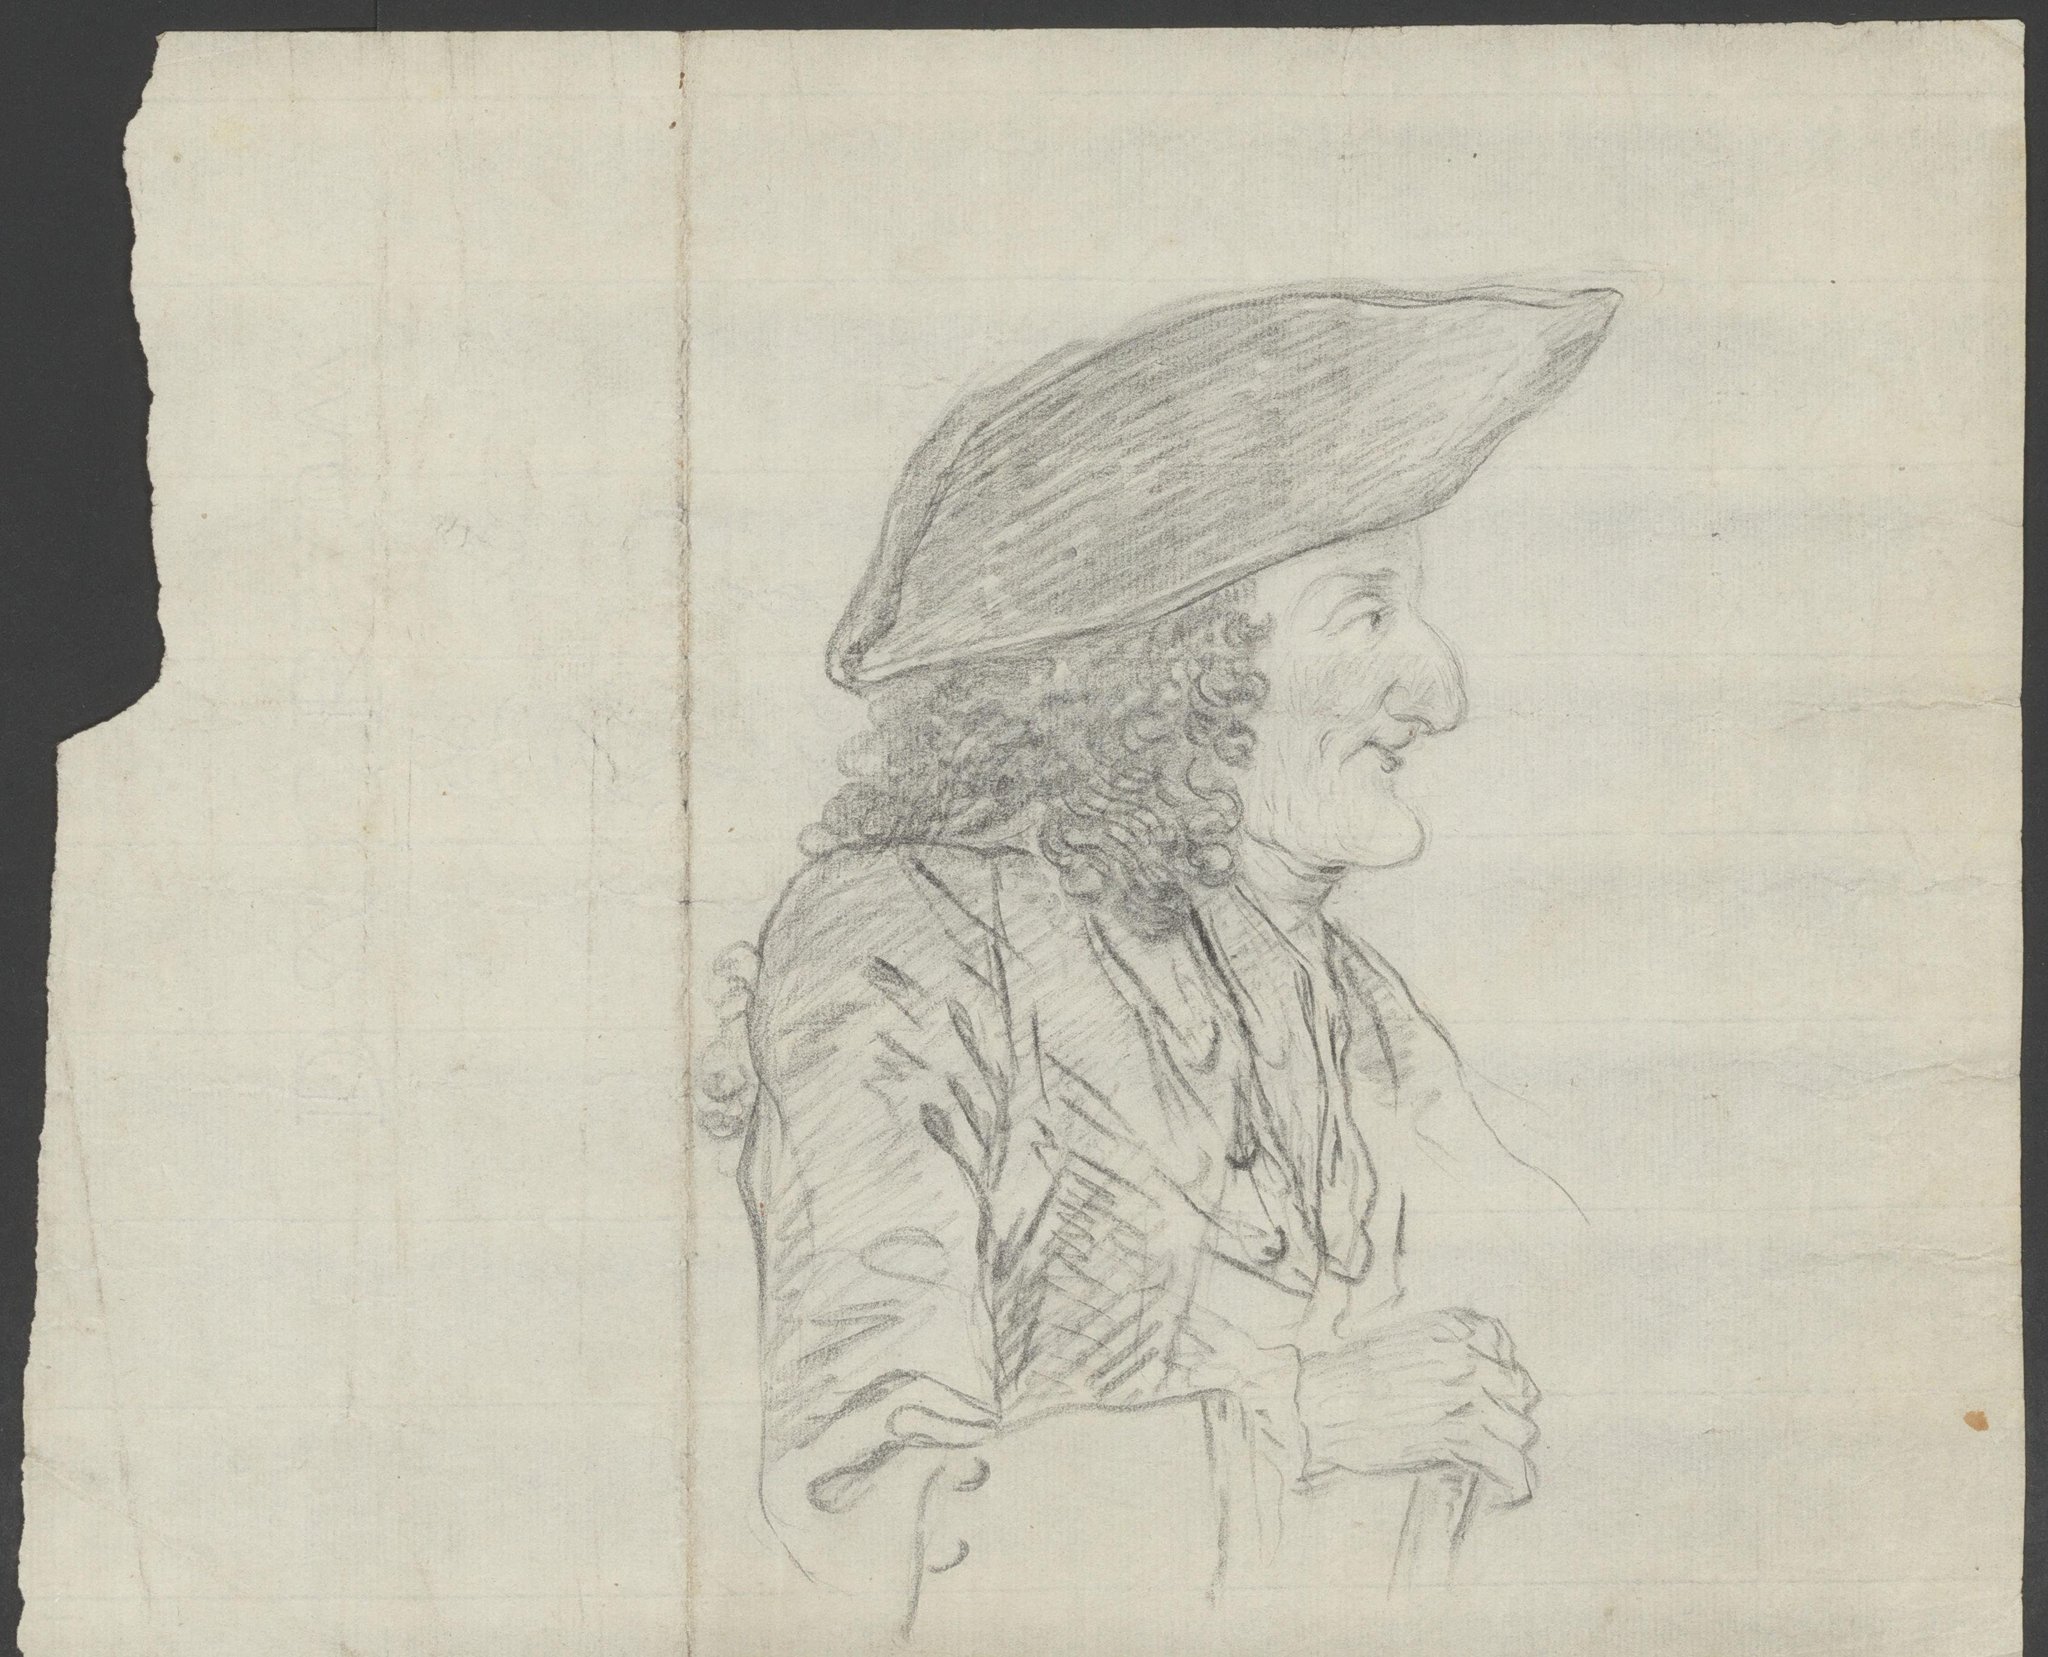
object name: drawing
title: Zijaanzicht van een man met steek en krullend haar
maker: jean bernard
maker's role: draughtsman, print maker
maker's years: 1765-1833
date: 1775-1833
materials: chalk, paper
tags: head-gear: bicorne, bicorn, face (+ sideview, profile), adult man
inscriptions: stamp, collector's mark: Lugt 1641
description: Onderwerpsrubrieken binnen de Atlas Zeden en Gewoonten: Schoone kunsten, Schilderkunst, Tekeningen.